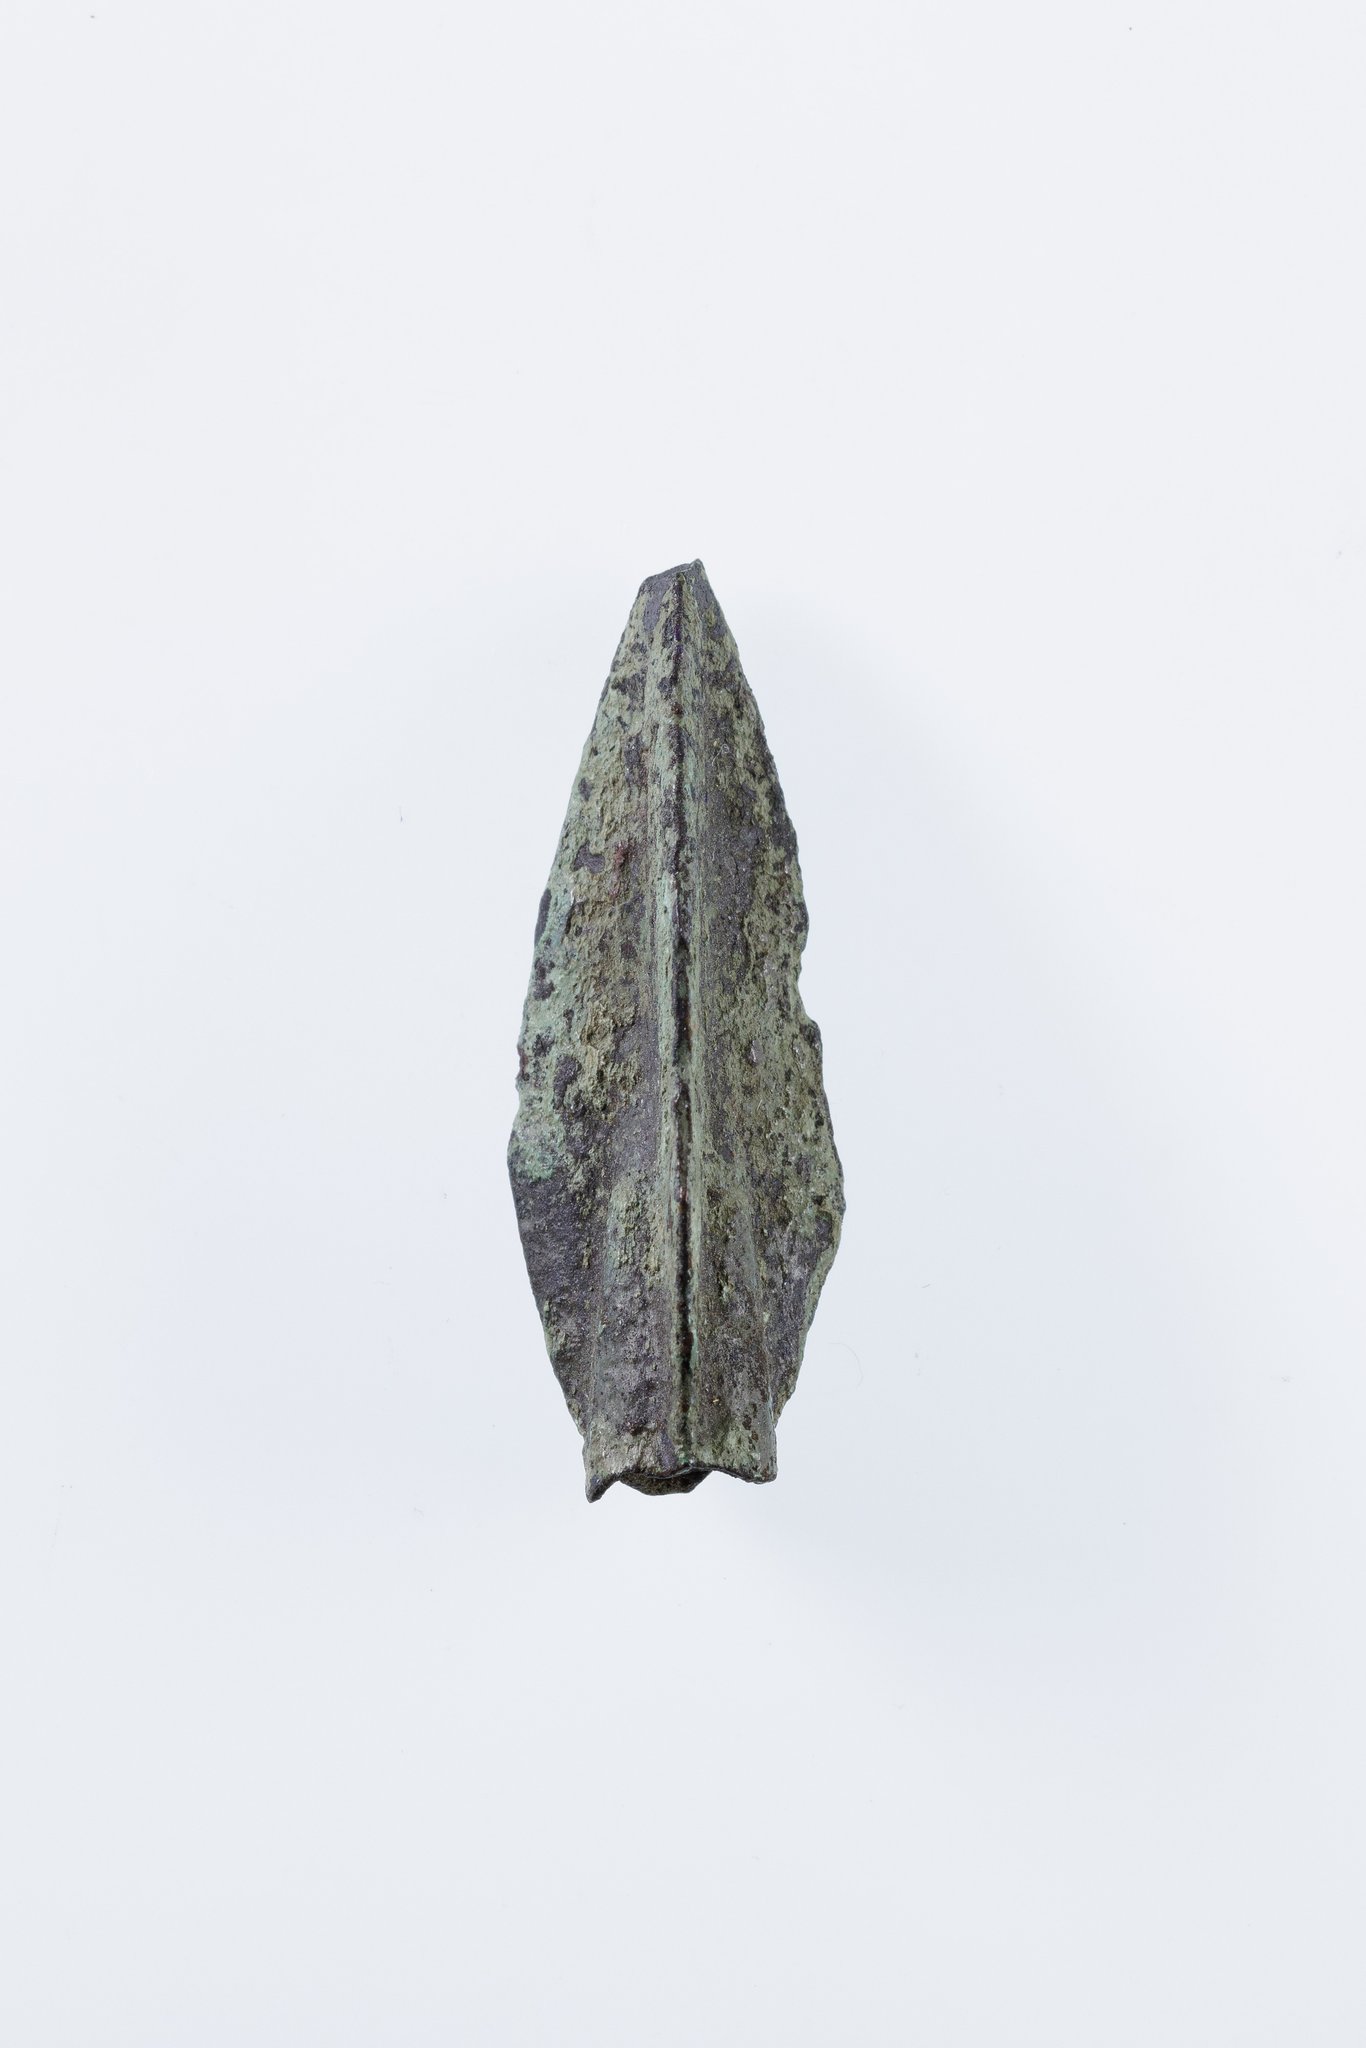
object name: arrow point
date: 664-525 BCE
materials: bronze, copper alloy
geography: egypt